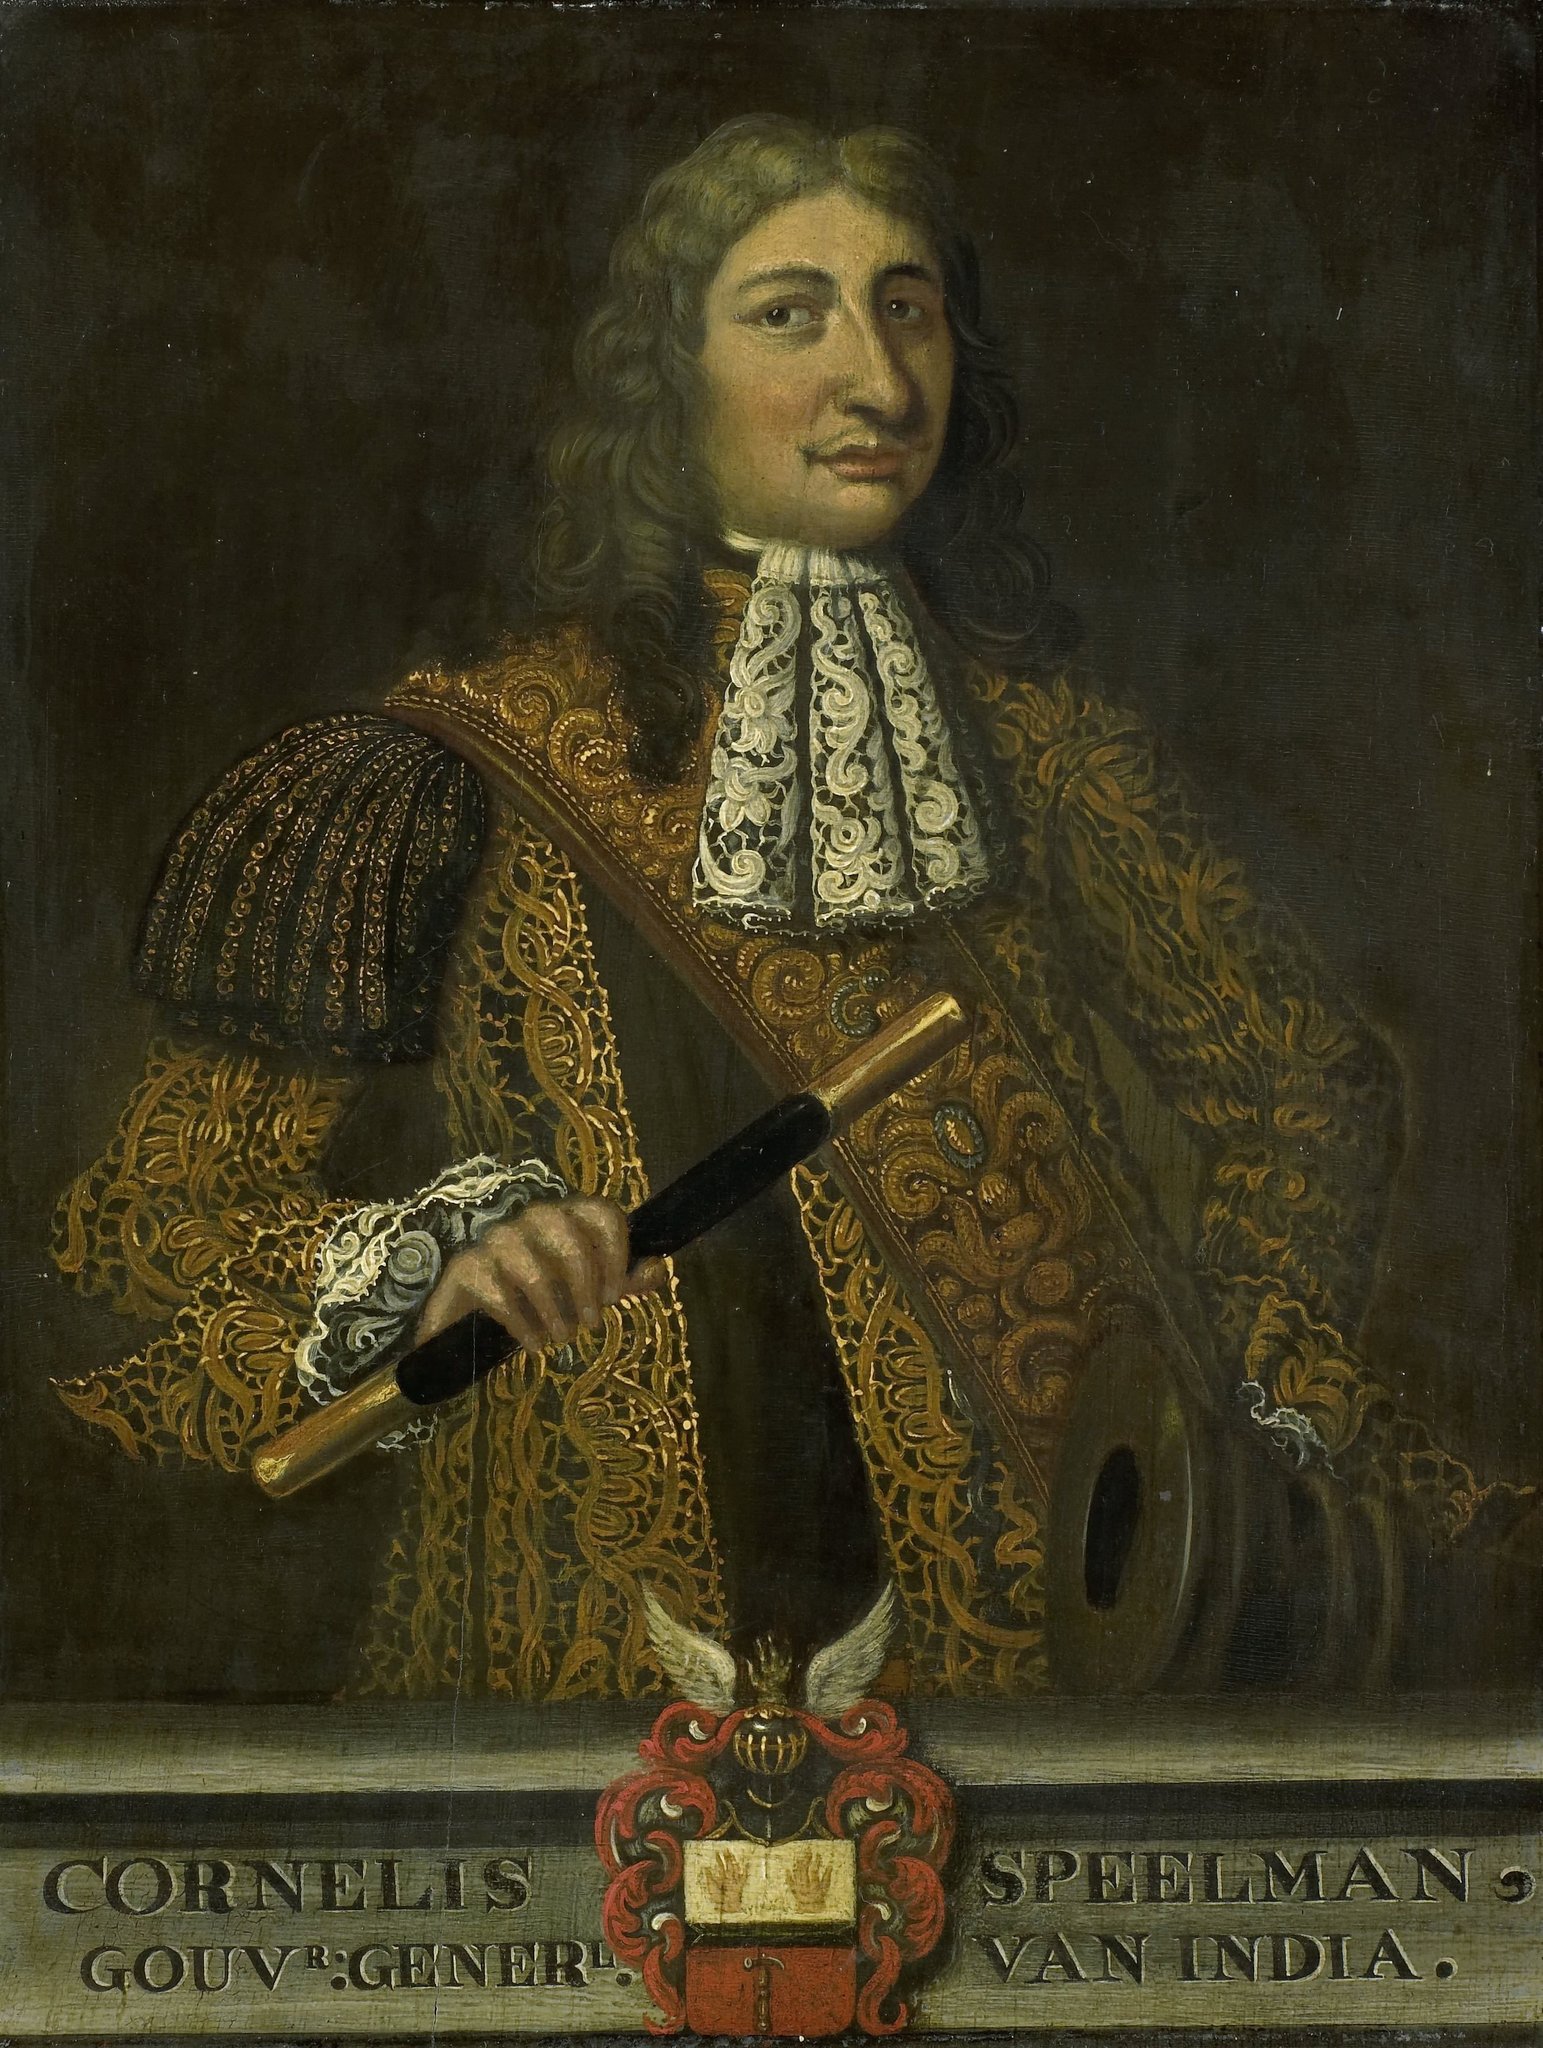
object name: painting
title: Portrait of Cornelis Speelman, Governor-General of the Dutch East Indies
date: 1750-1800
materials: oil, panel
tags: rotterdam, batavia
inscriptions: inscription: ‘Cornelis Speelman, Gouv.r Gener.l van India.’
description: Portraits of the governors general. At the head of the VOC administration in Asia was the governor general, the chairman of the East Indies Council, which met in Batavia. The Council's assembly chamber at the Castle in Batavia was the focal point of Dutch power. Along the walls hung the portraits of all the past governors general, symbolising the continuity of the Dutch presence. Smaller copies at the Company's offices in the Netherlands represented the VOC's power in Asia. The copies displayed here probably come from the VOC's Rotterdam Chamber. Some of the portraits from the series that hung in Batavia are displayed above in the VOC gallery that circles this room. Pieter Both, 1610-1614 Gerard Reynst, 1614-1615 Laurens Reael,1615-1619 Jan Pietersz Coen, 1619-1623 and 1627-1629 Pieter de Carpentier, 1623-1627 Jacques Specx, 1629-1632 Hendrick Brouwer, 1632-1636 Antonio van Diemen, 1636-1645 Cornelis van der Lijn, 1645-1650 Karel Reiniersz, 1650-1653 Joan Maetsuycker, 1653-1678 Rycklof van Goens, 1678-1681 Cornelis Speelman, 1681-1684 Johannes Camphuys, 1684-1691 Willem van Outshoorn, 1691-1704 Abraham van Riebeeck, 1709-1713 Christoffel van Swoll, 1713-1718 Hendrick Zwaardecroon, 1718-1725 Mattheus de Haan, 1725-1729 The portrait of Joan van Hoorn, 1704-1709, is missing.